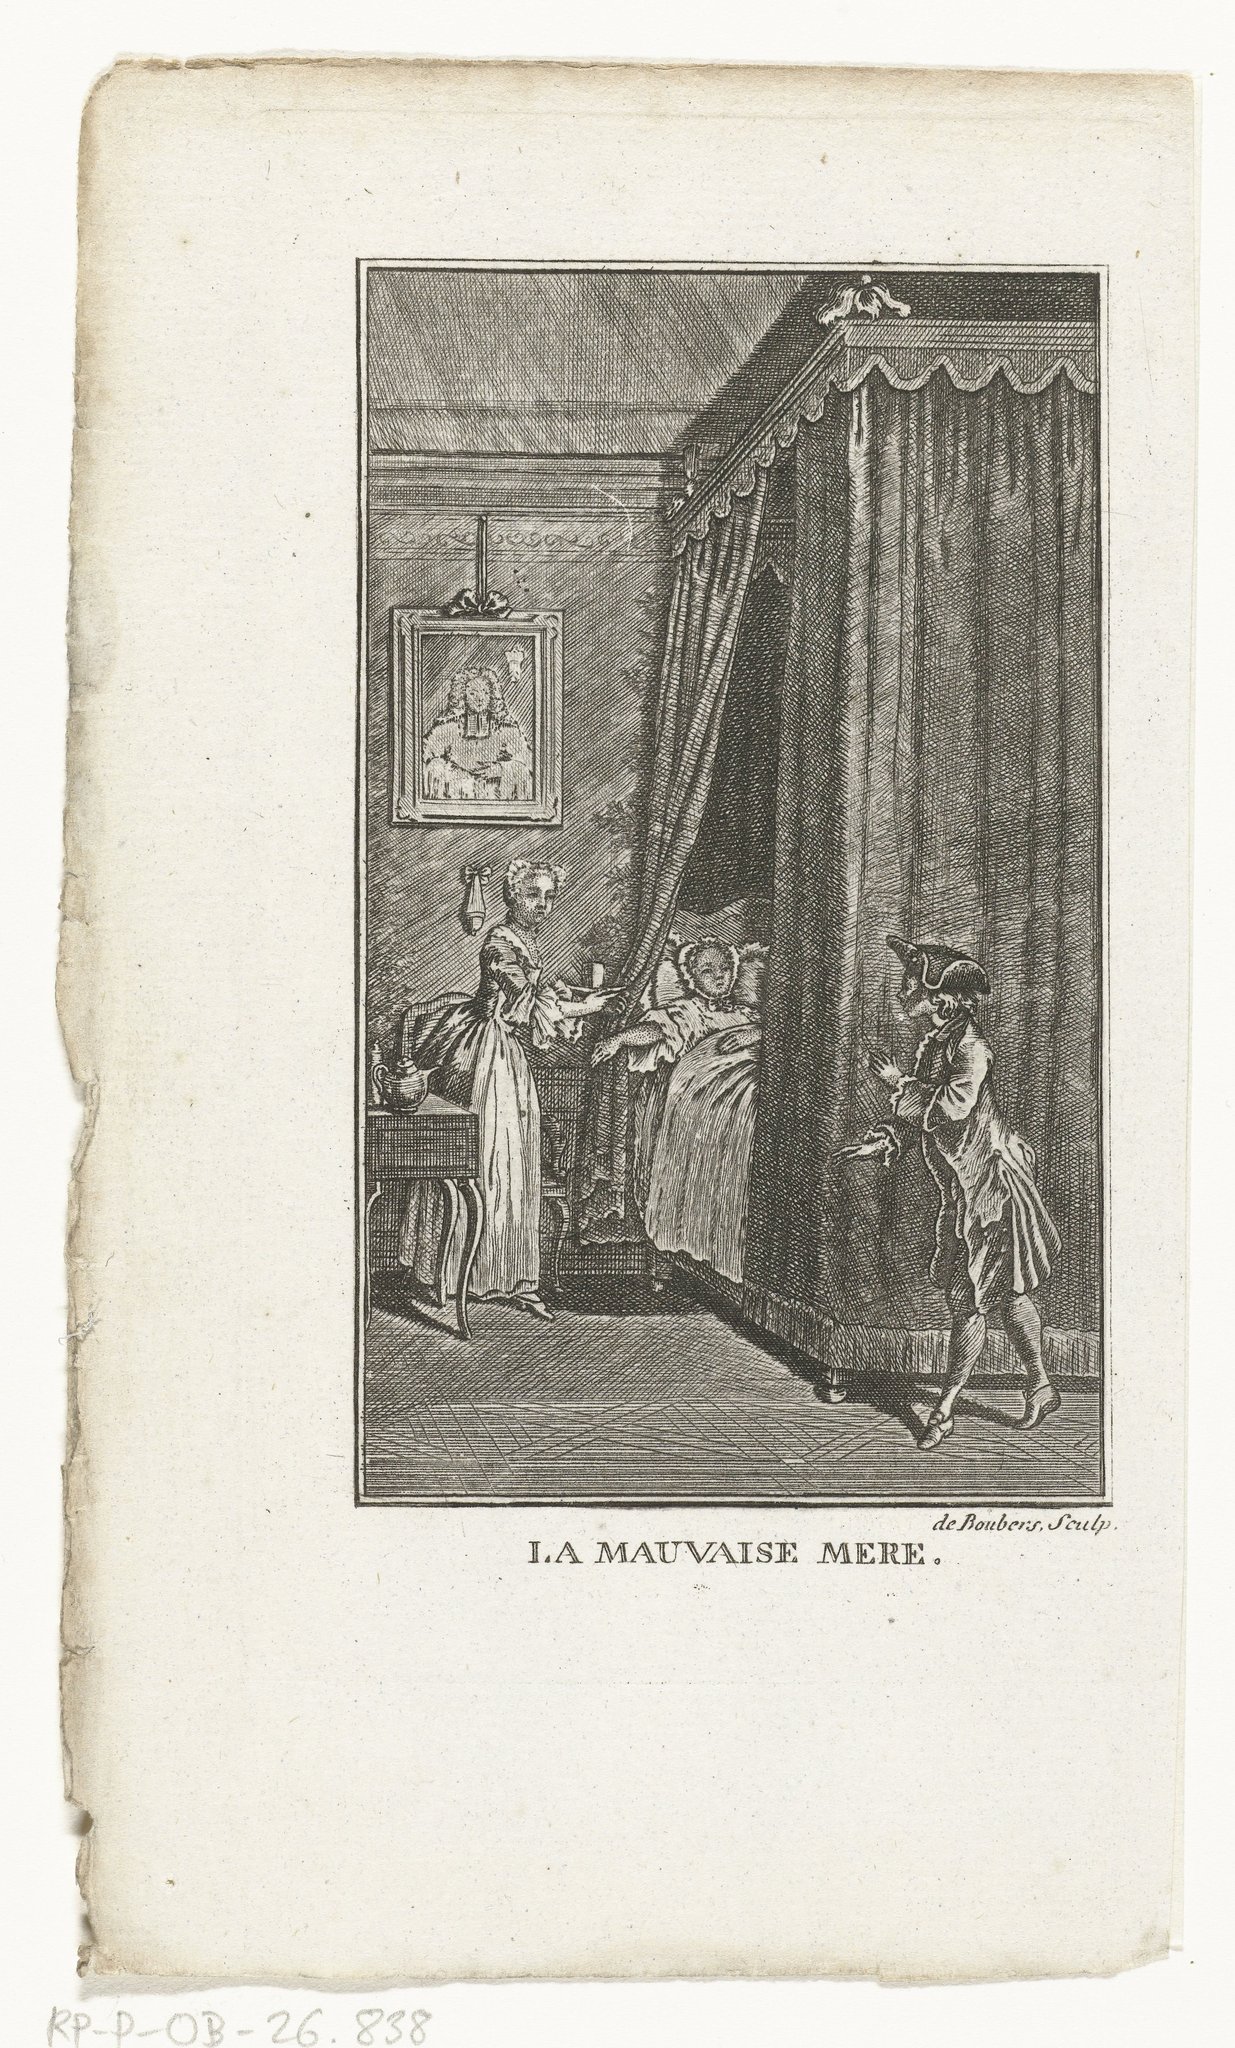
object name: print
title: La Mauvaise Mere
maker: n. de boubers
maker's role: print maker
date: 1765-1780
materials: paper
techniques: engraving, etching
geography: paris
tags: absence of parental love, filial love, 'pietas filiorum'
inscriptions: collector's mark: Lugt 2228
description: Illustratie voor het verhaal 'La Mauvaise Mere' uit J.F. Marmontel's verhalenbundel 'Contes moreaux'. Een moeder ligt ziek op bed. Haar dochter en zoon moeten voor haar zorgen. De dochter brengt een glas water, de zoon loopt op de puntjes van zijn tenen om zo min mogelijk geluid te maken.